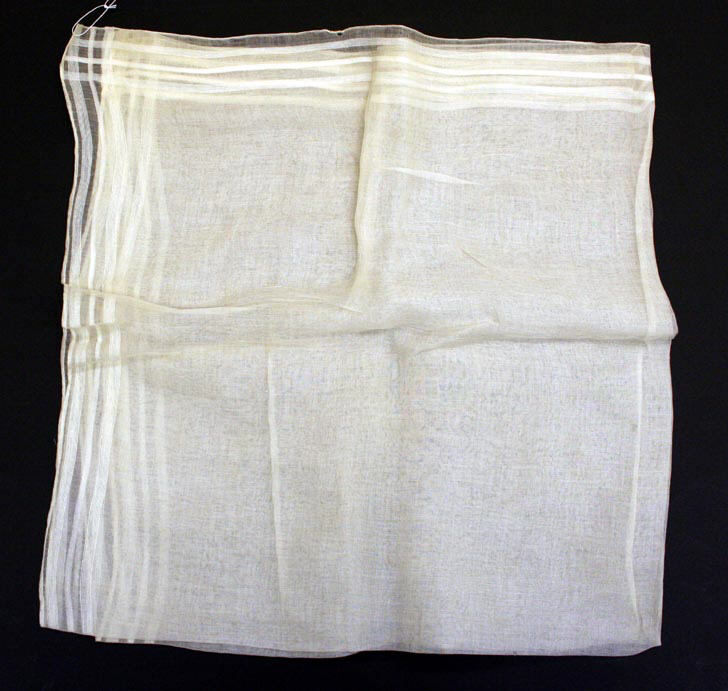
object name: accessory set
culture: american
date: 1700-1942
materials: cotton